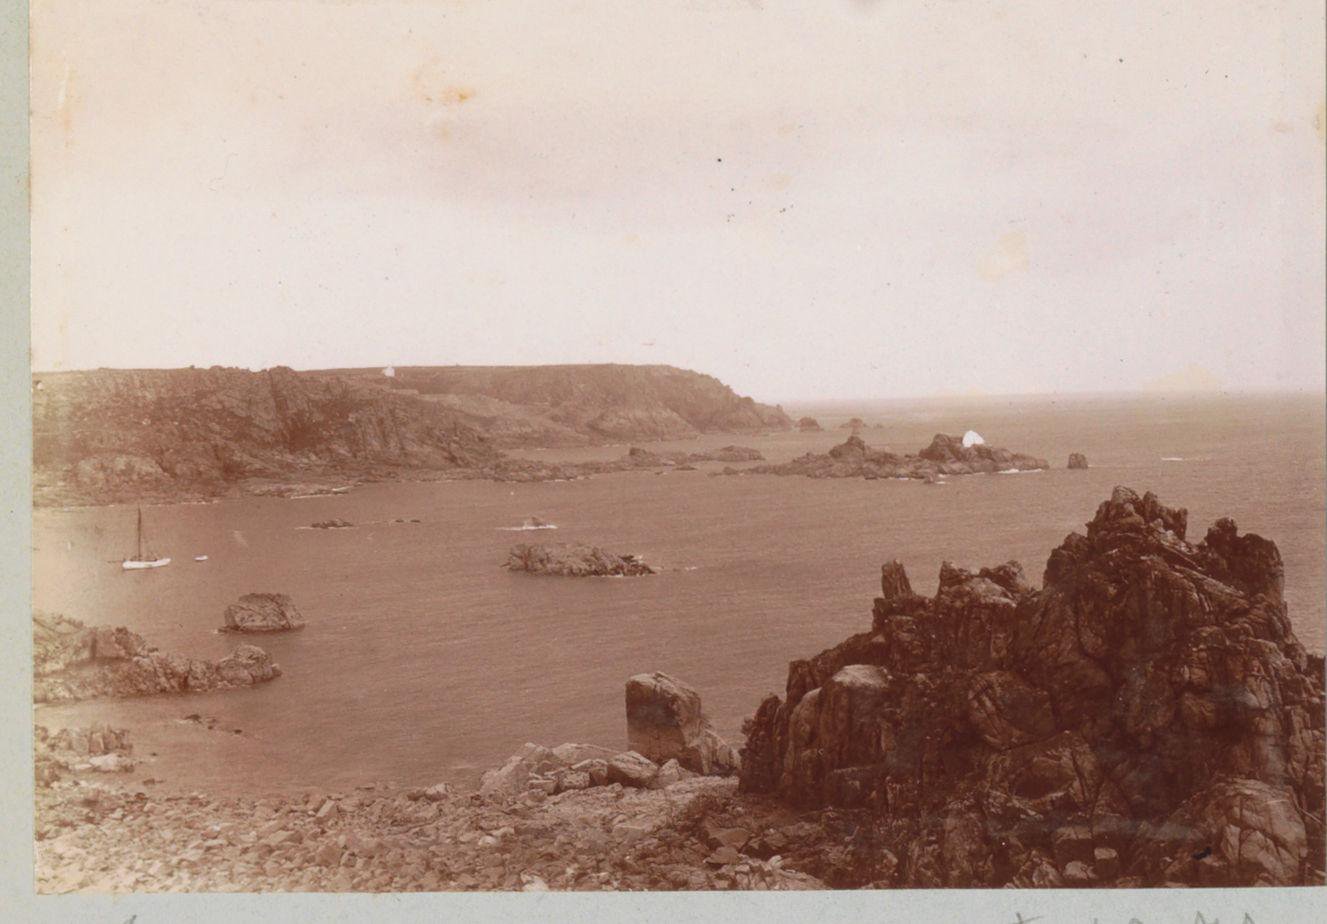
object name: photograph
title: Gezicht op rotsformaties en een baai op Jersey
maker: delizy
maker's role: manufacturer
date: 1896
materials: paper, photographic support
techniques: gelatin silver print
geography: jersey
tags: gulf, bay (+ landscape with figures, staffage), rock-formations, coast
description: Onderdeel van Fotoalbum van een Franse amateurfotograaf met opnames van uitstapjes in Frankrijk, Spanje, België, Luxemburg en Nederland, de eerste automobielen en autoraces.